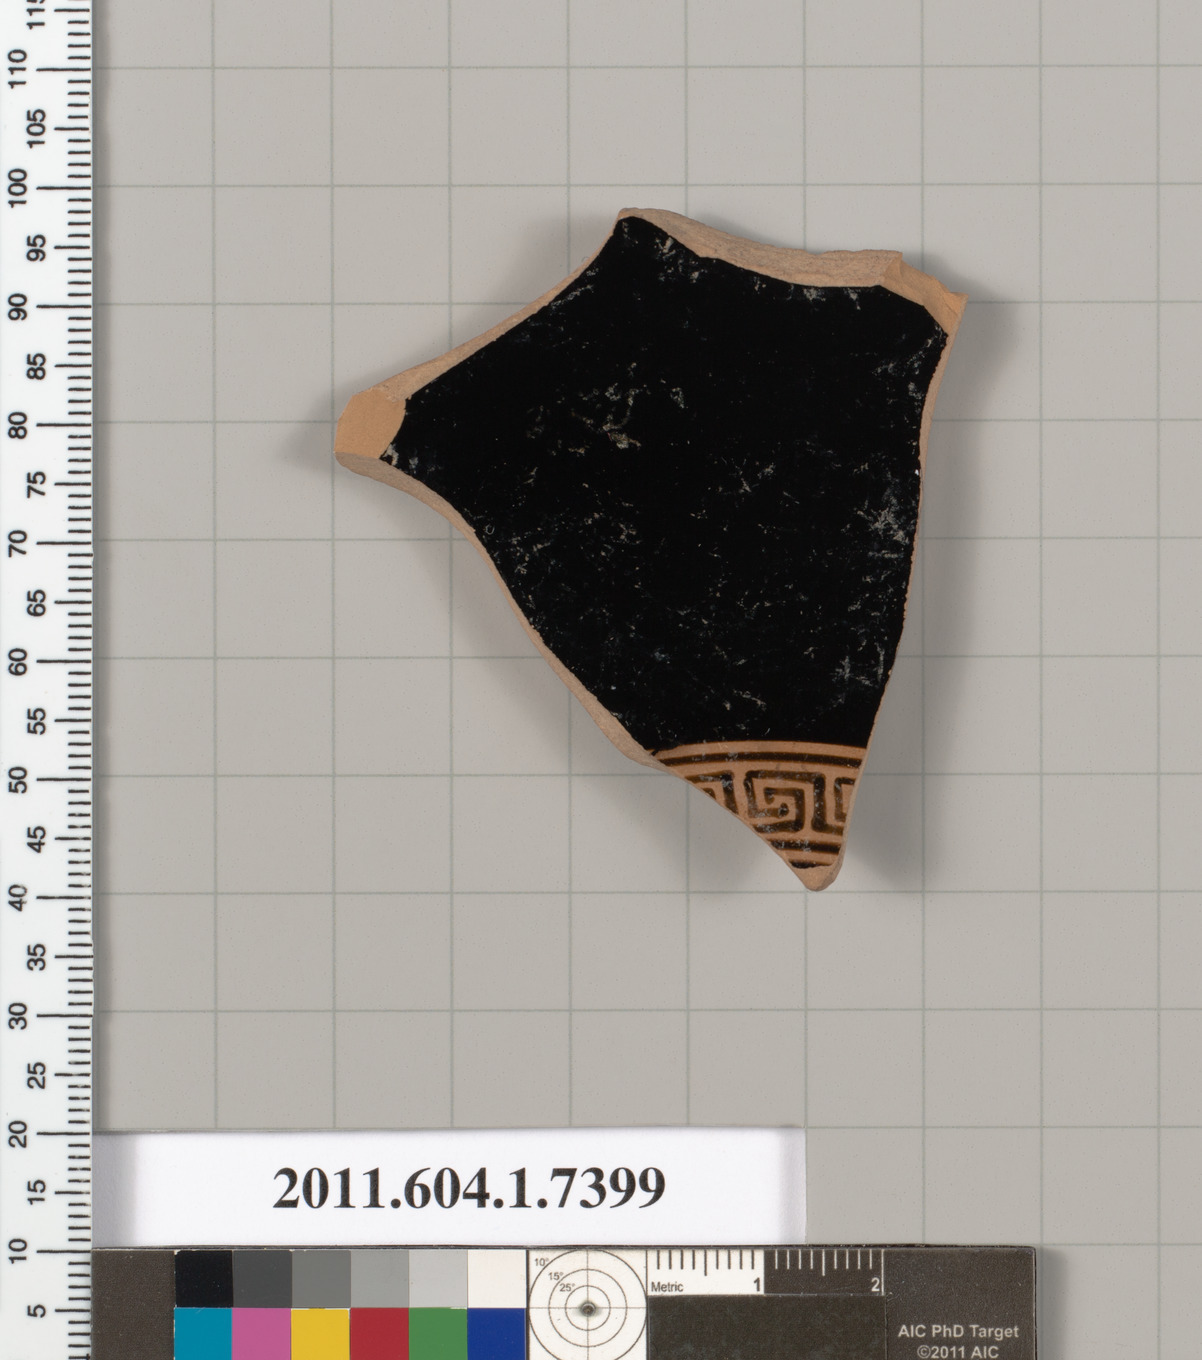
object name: kylix fragment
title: Terracotta fragment of a kylix (drinking cup)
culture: greek, attic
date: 500-480 BCE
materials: terracotta